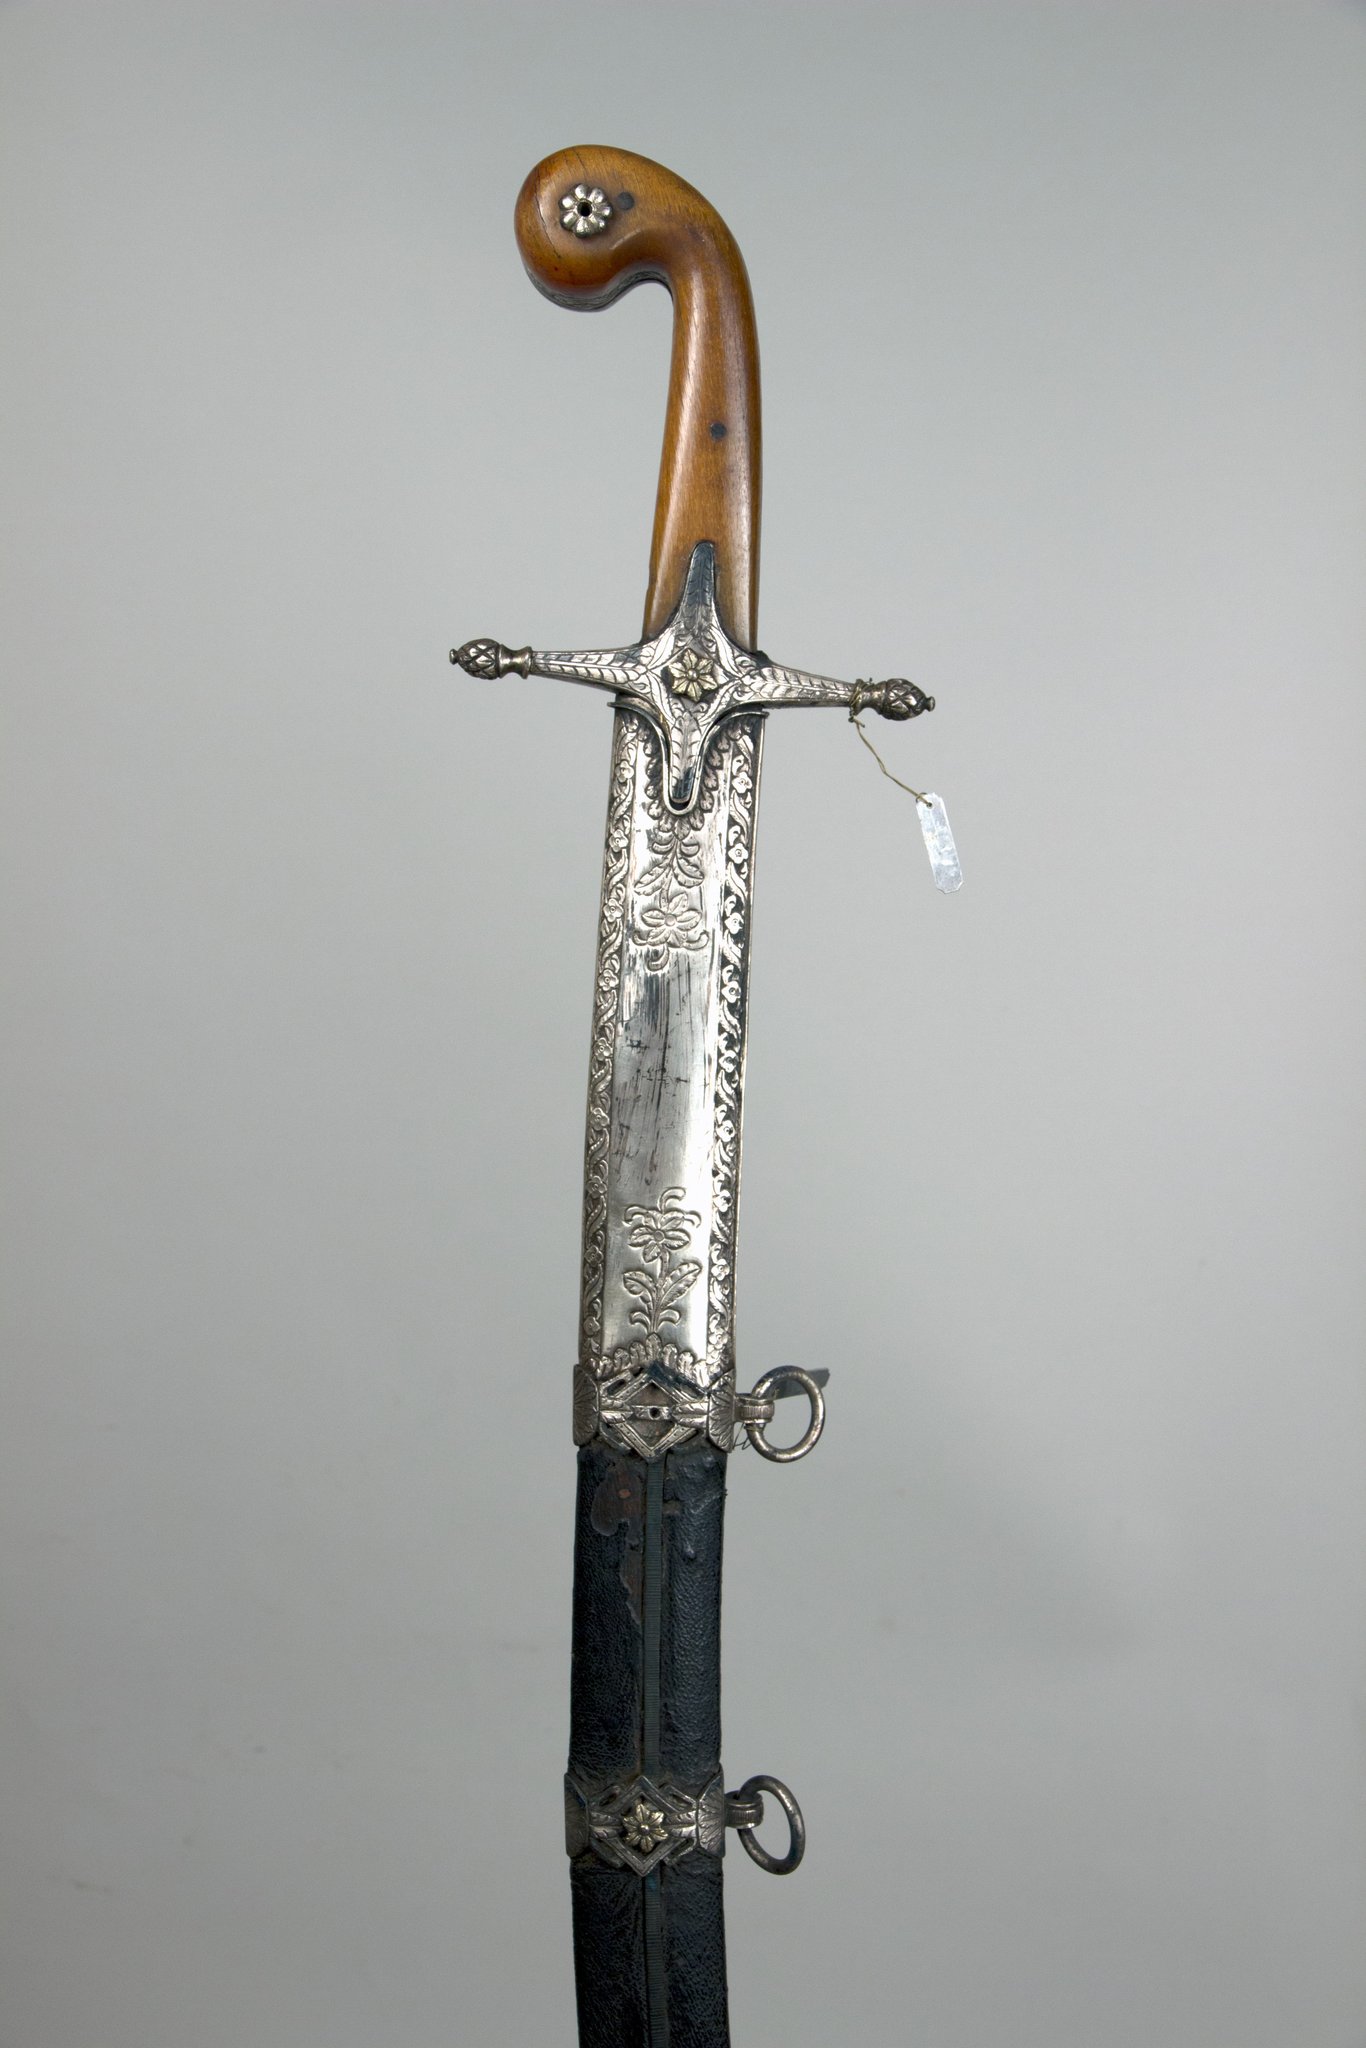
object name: sword kilij and scabbard with baldric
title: Sword (Kilij) and Scabbard with Baldric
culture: turkish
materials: gold, horn, leather, silk, silver, steel, wood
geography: ottoman empire